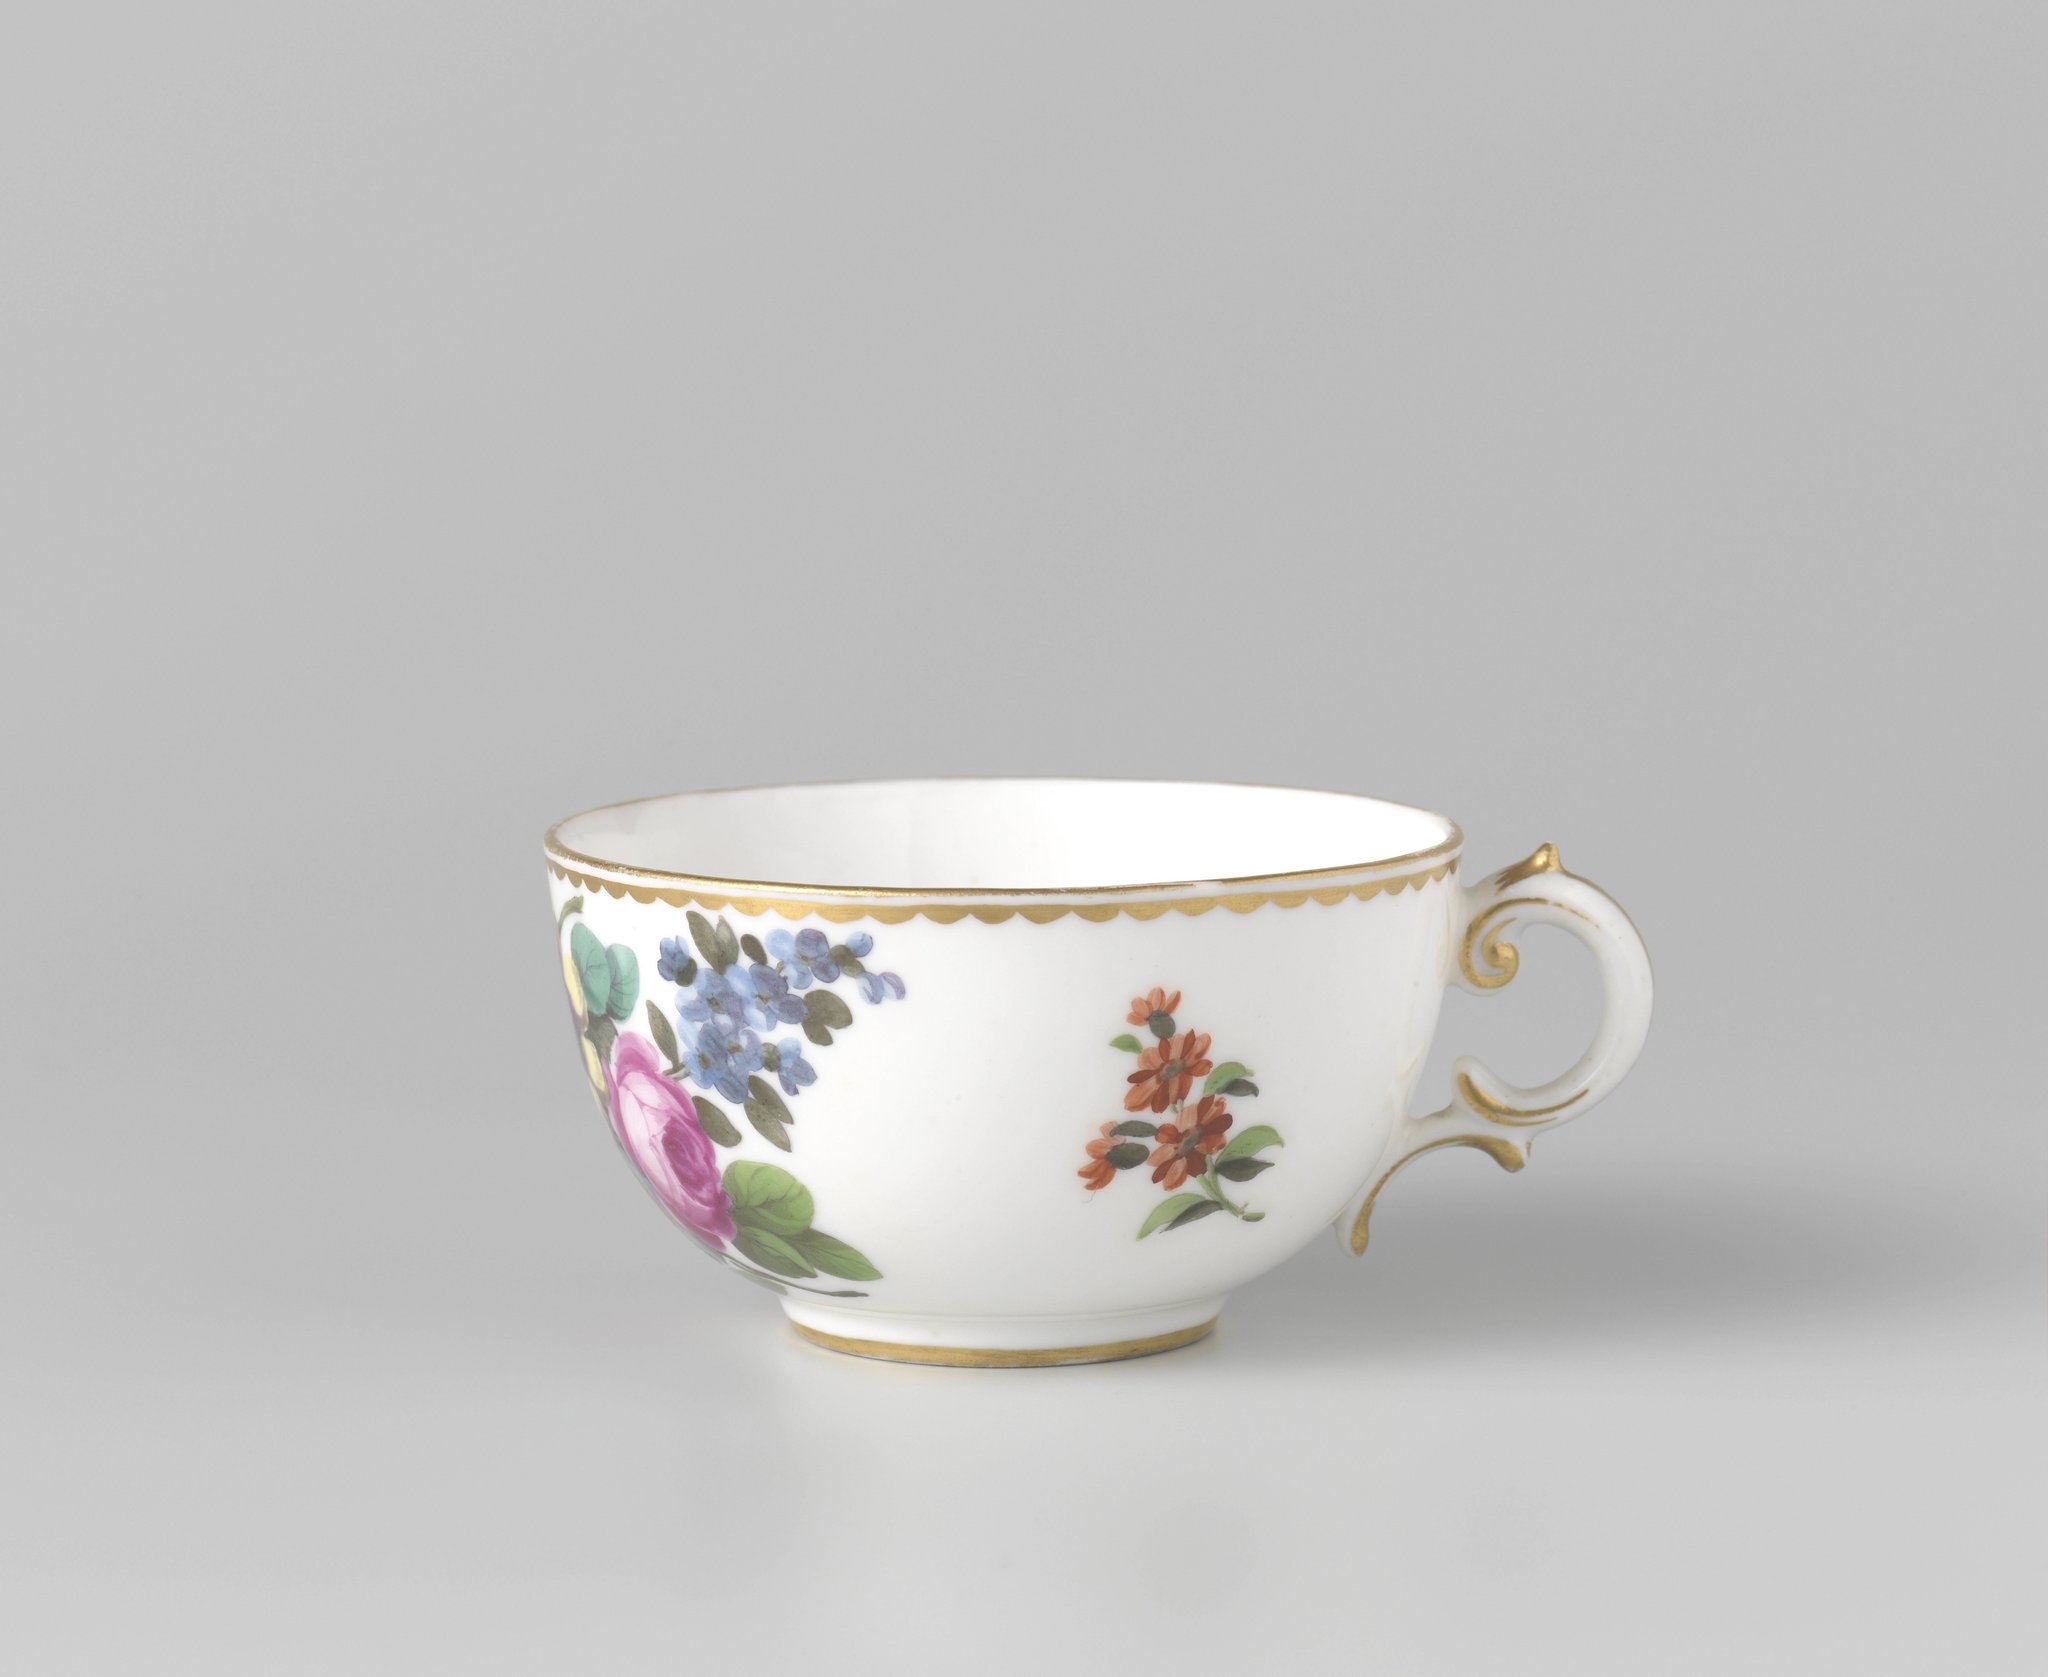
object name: cup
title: Tea service for two people (tête-à-tête)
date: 1778-1782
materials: porcelain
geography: loosdrecht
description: Manufactuur Oud-Loosdrecht Loosdrecht, c. 1778–1782 hard-paste porcelain